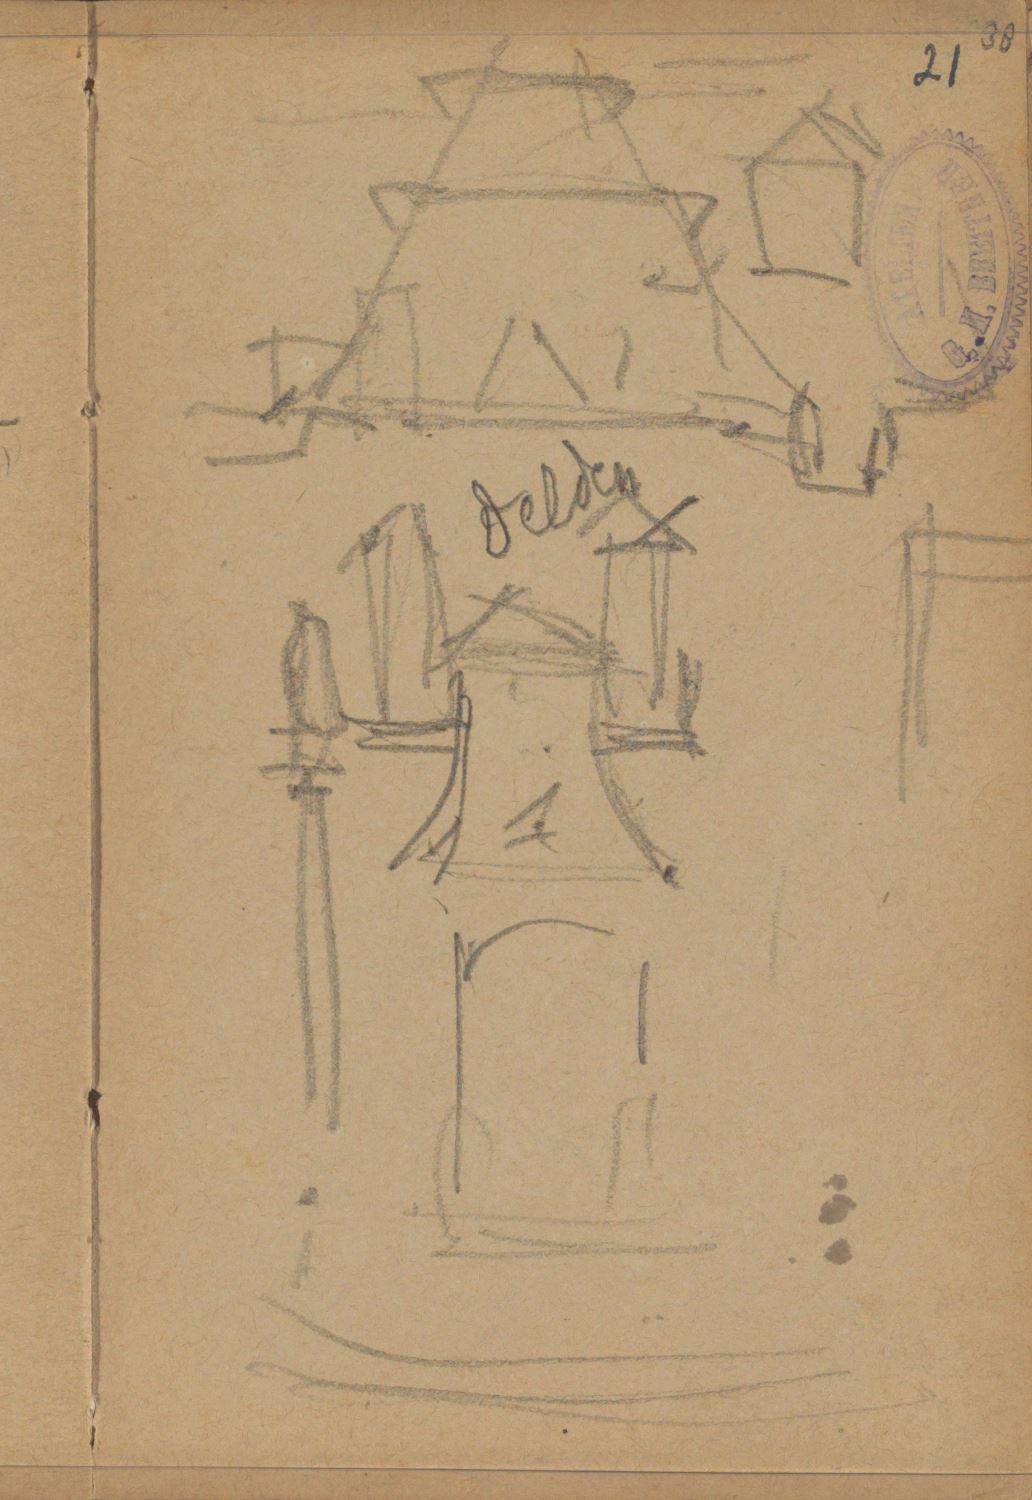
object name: sketchbook leaf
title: Ingangspartij van Kasteel Twickel te Delden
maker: george hendrik breitner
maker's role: draughtsman, painter, print maker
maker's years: 1857-1923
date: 1887-1891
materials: paper, pencil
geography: delden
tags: castle, gate, entrance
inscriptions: annotation: ‘Delden’, workshop stamp: Lugt 291d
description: Pagina 38 uit een schetsboek met 83 bladen.